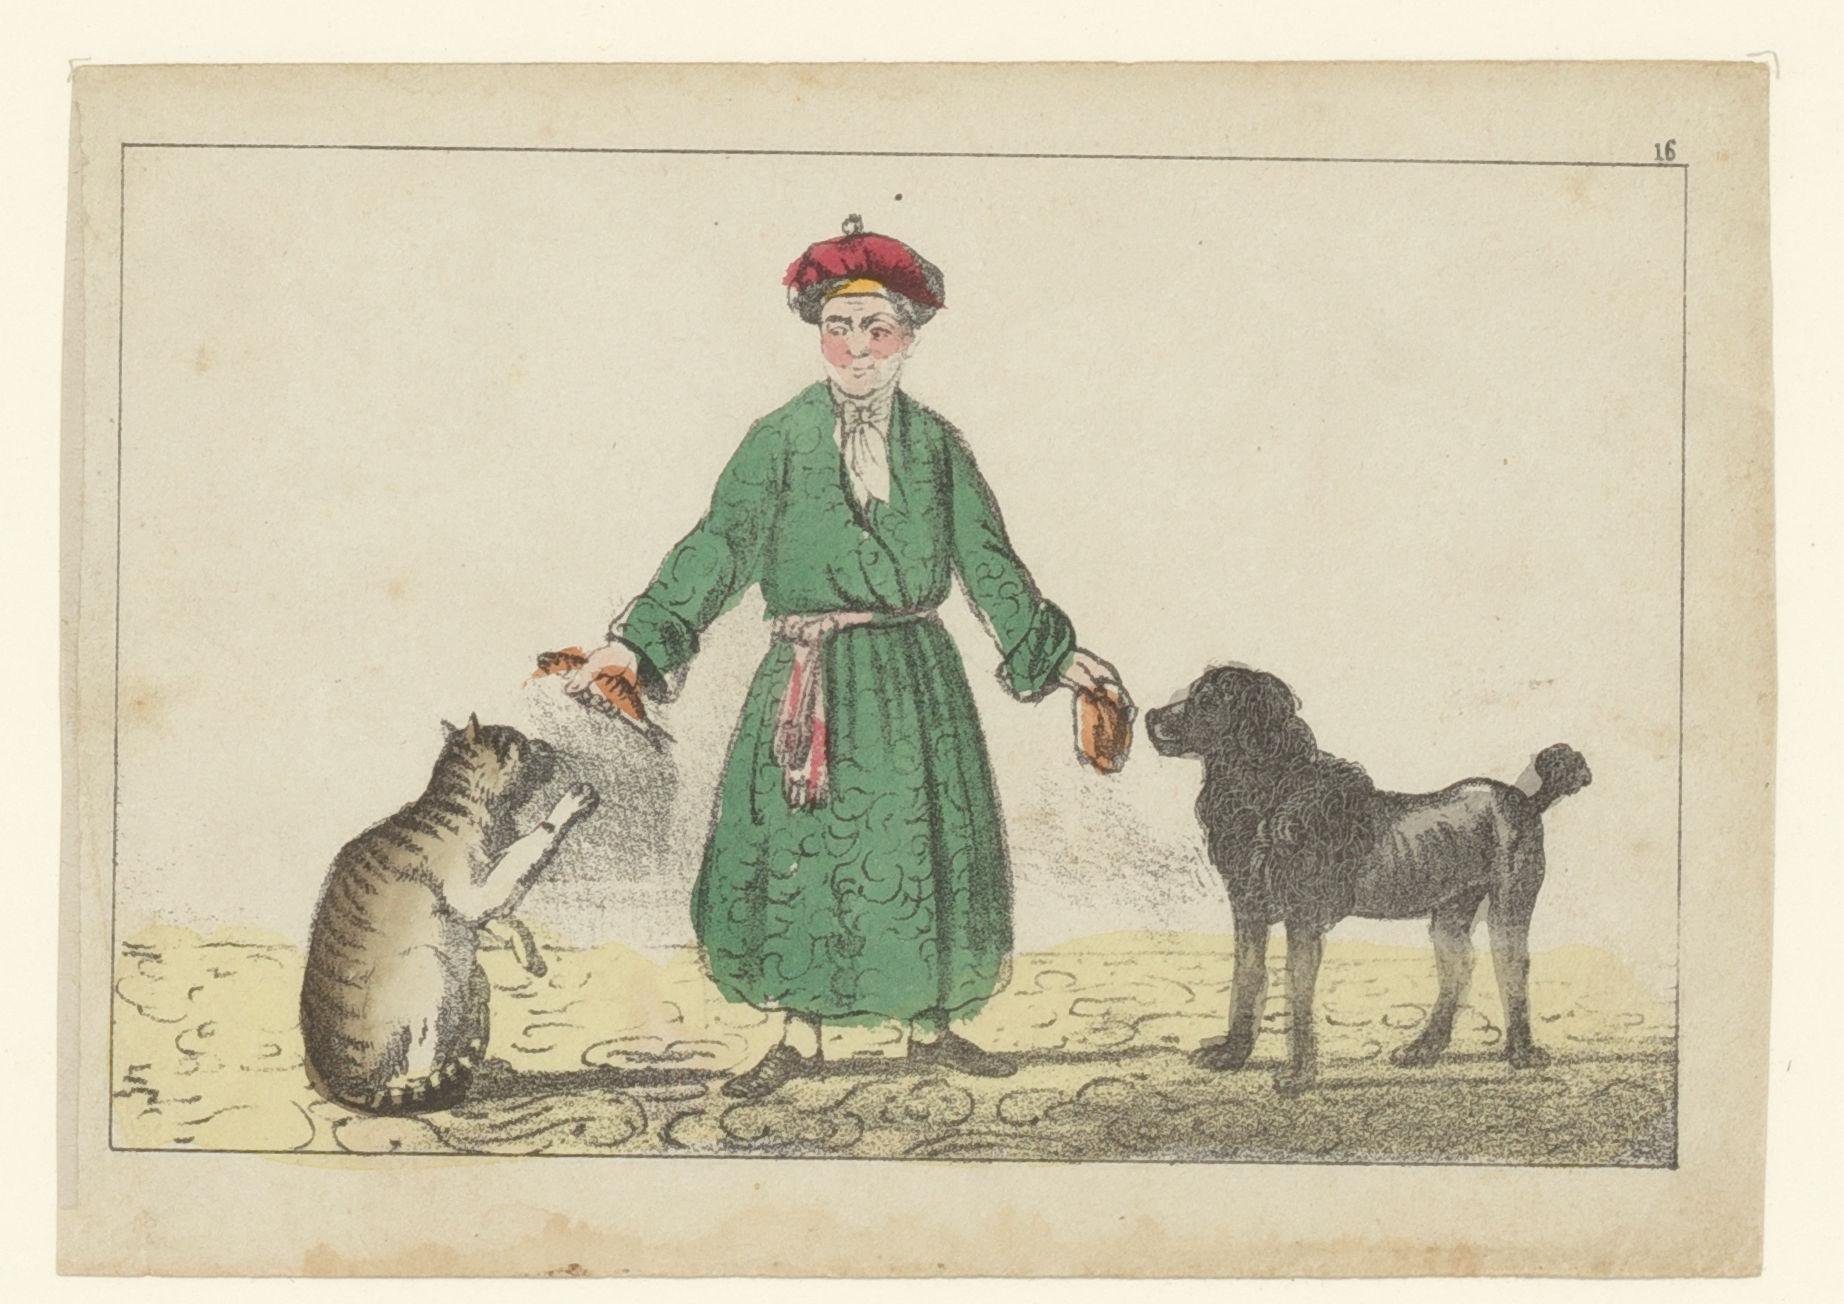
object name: print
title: Kardoes en Muizenschrik worden beloont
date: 1841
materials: paper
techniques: hand coloring, lithograph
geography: rotterdam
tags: cat, praise, approbation, approval; 'lode' (ripa), dog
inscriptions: collector's mark: Lugt 1641, stamp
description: Rechtsboven genummerd: 16. Onderwerpsrubrieken binnen de Atlas Zeden en Gewoonten: Zeden en Gewoonten in Engeren Zin, Des menschen beging, midden en einde, Kinderleven – Kinderspel en Kinderprenten.